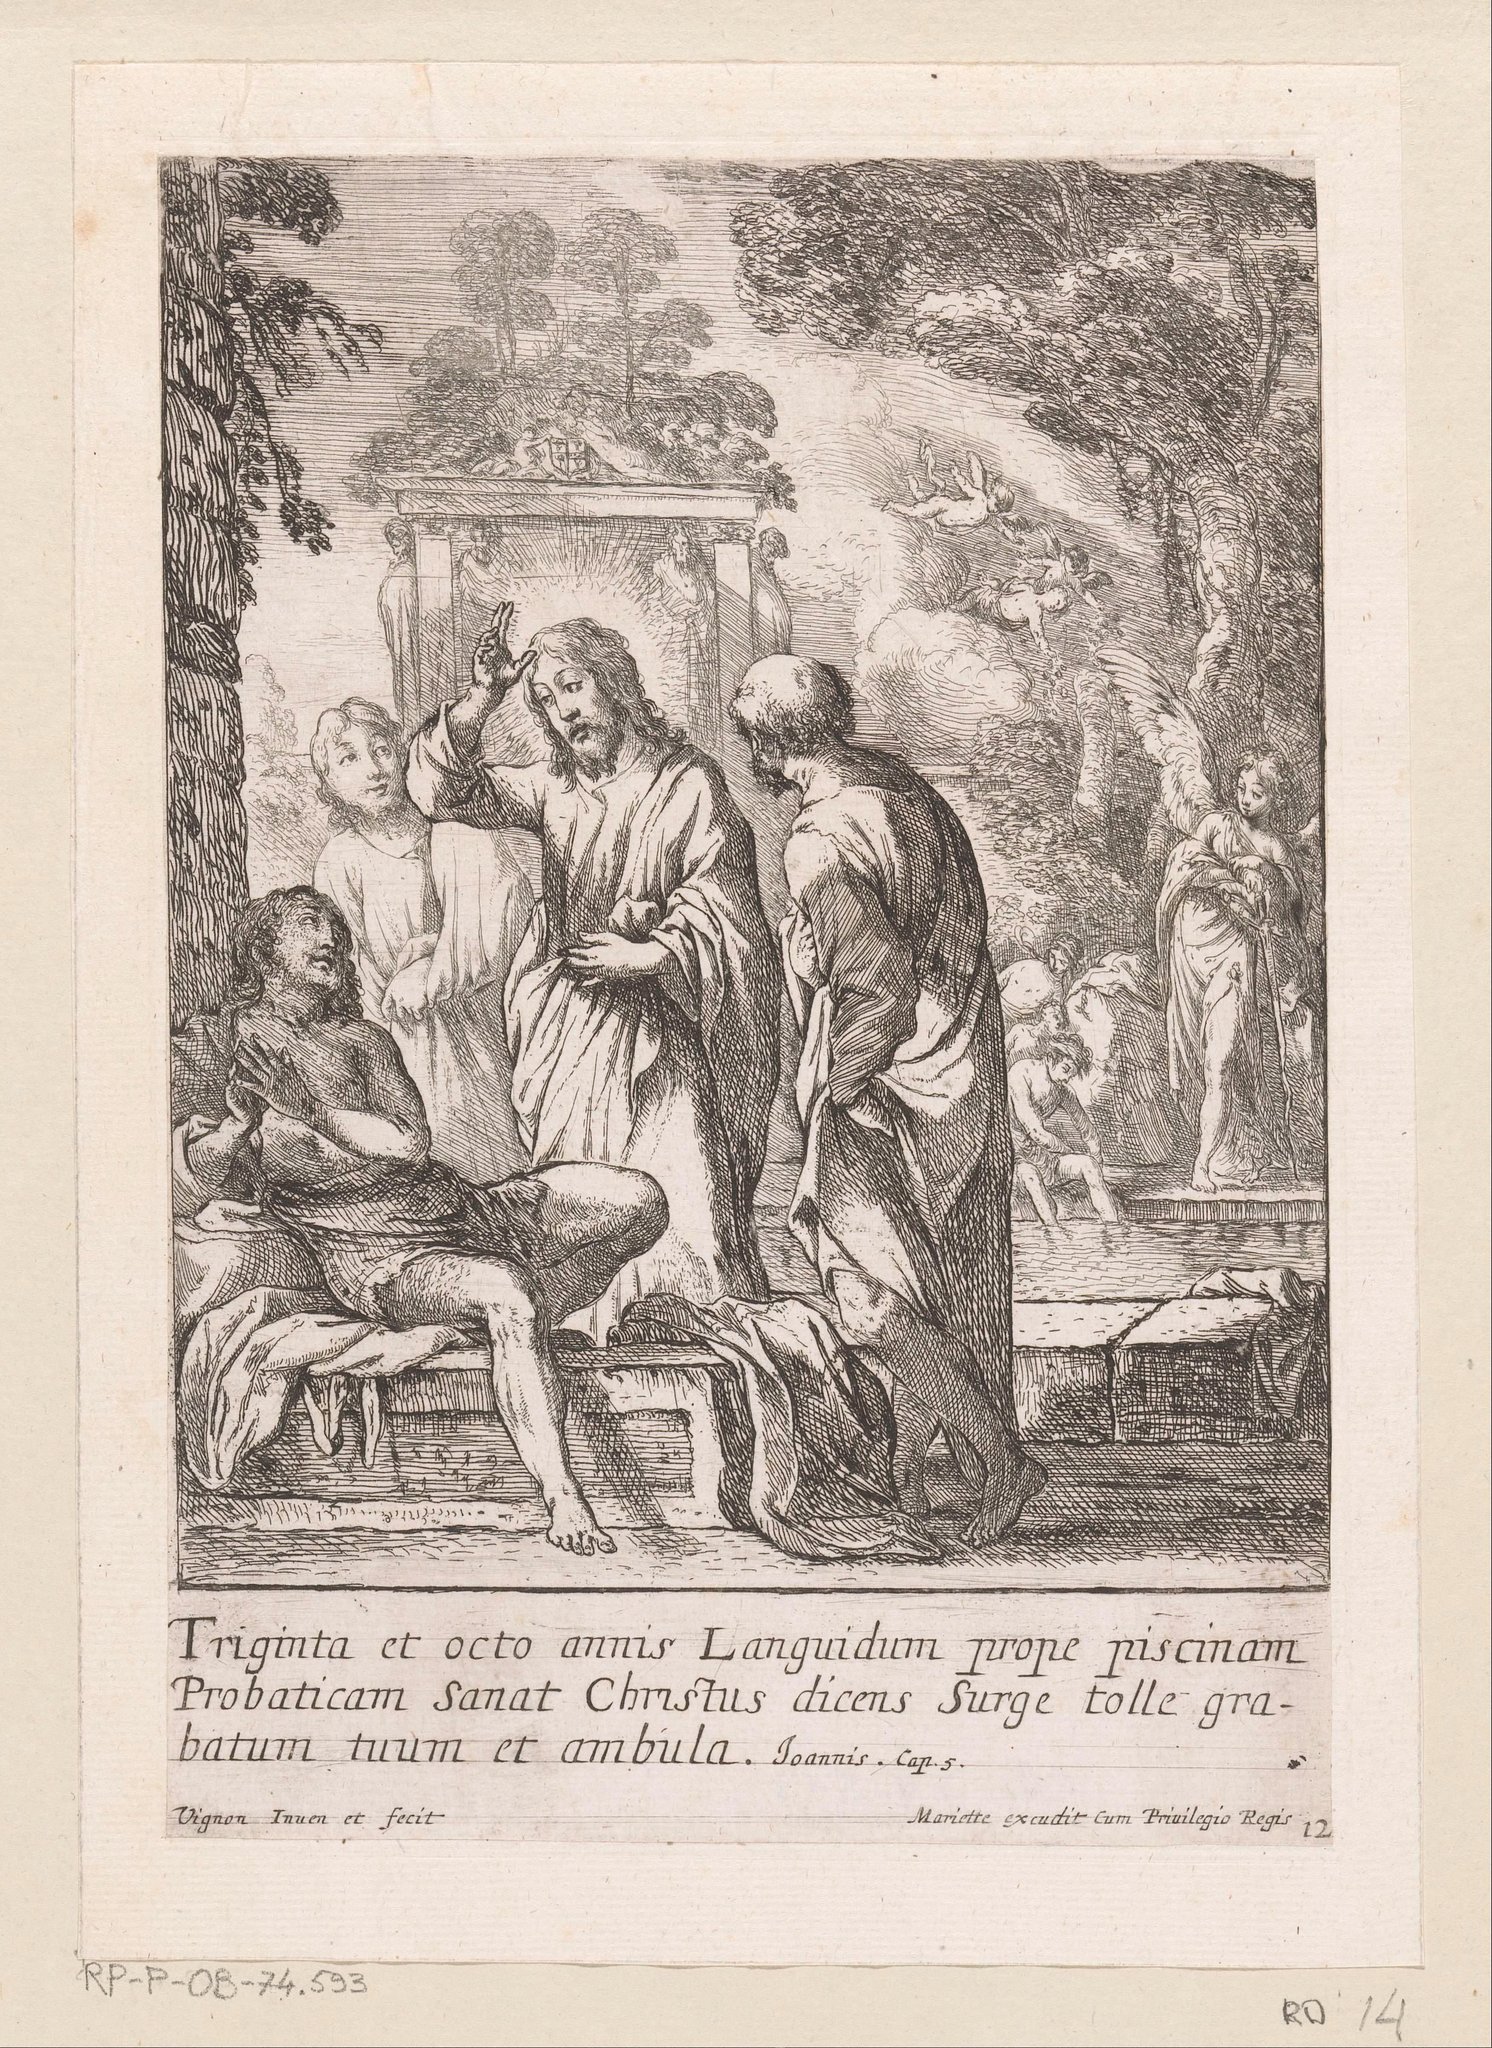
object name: print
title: Genezing van de man bij het bad te Betesda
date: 1638-1643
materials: paper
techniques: drypoint, etching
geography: paris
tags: sick people lying near the pool of bethesda ~ christ healing paralytics (john 5:1-9), miracles of christ ~ healing the sick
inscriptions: collector's mark: Lugt 240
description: Maakt deel uit van een serie van dertien prenten voorstellende de wonderen van Christus, opgedragen aan de arts Charles Delorme (1584-1678).